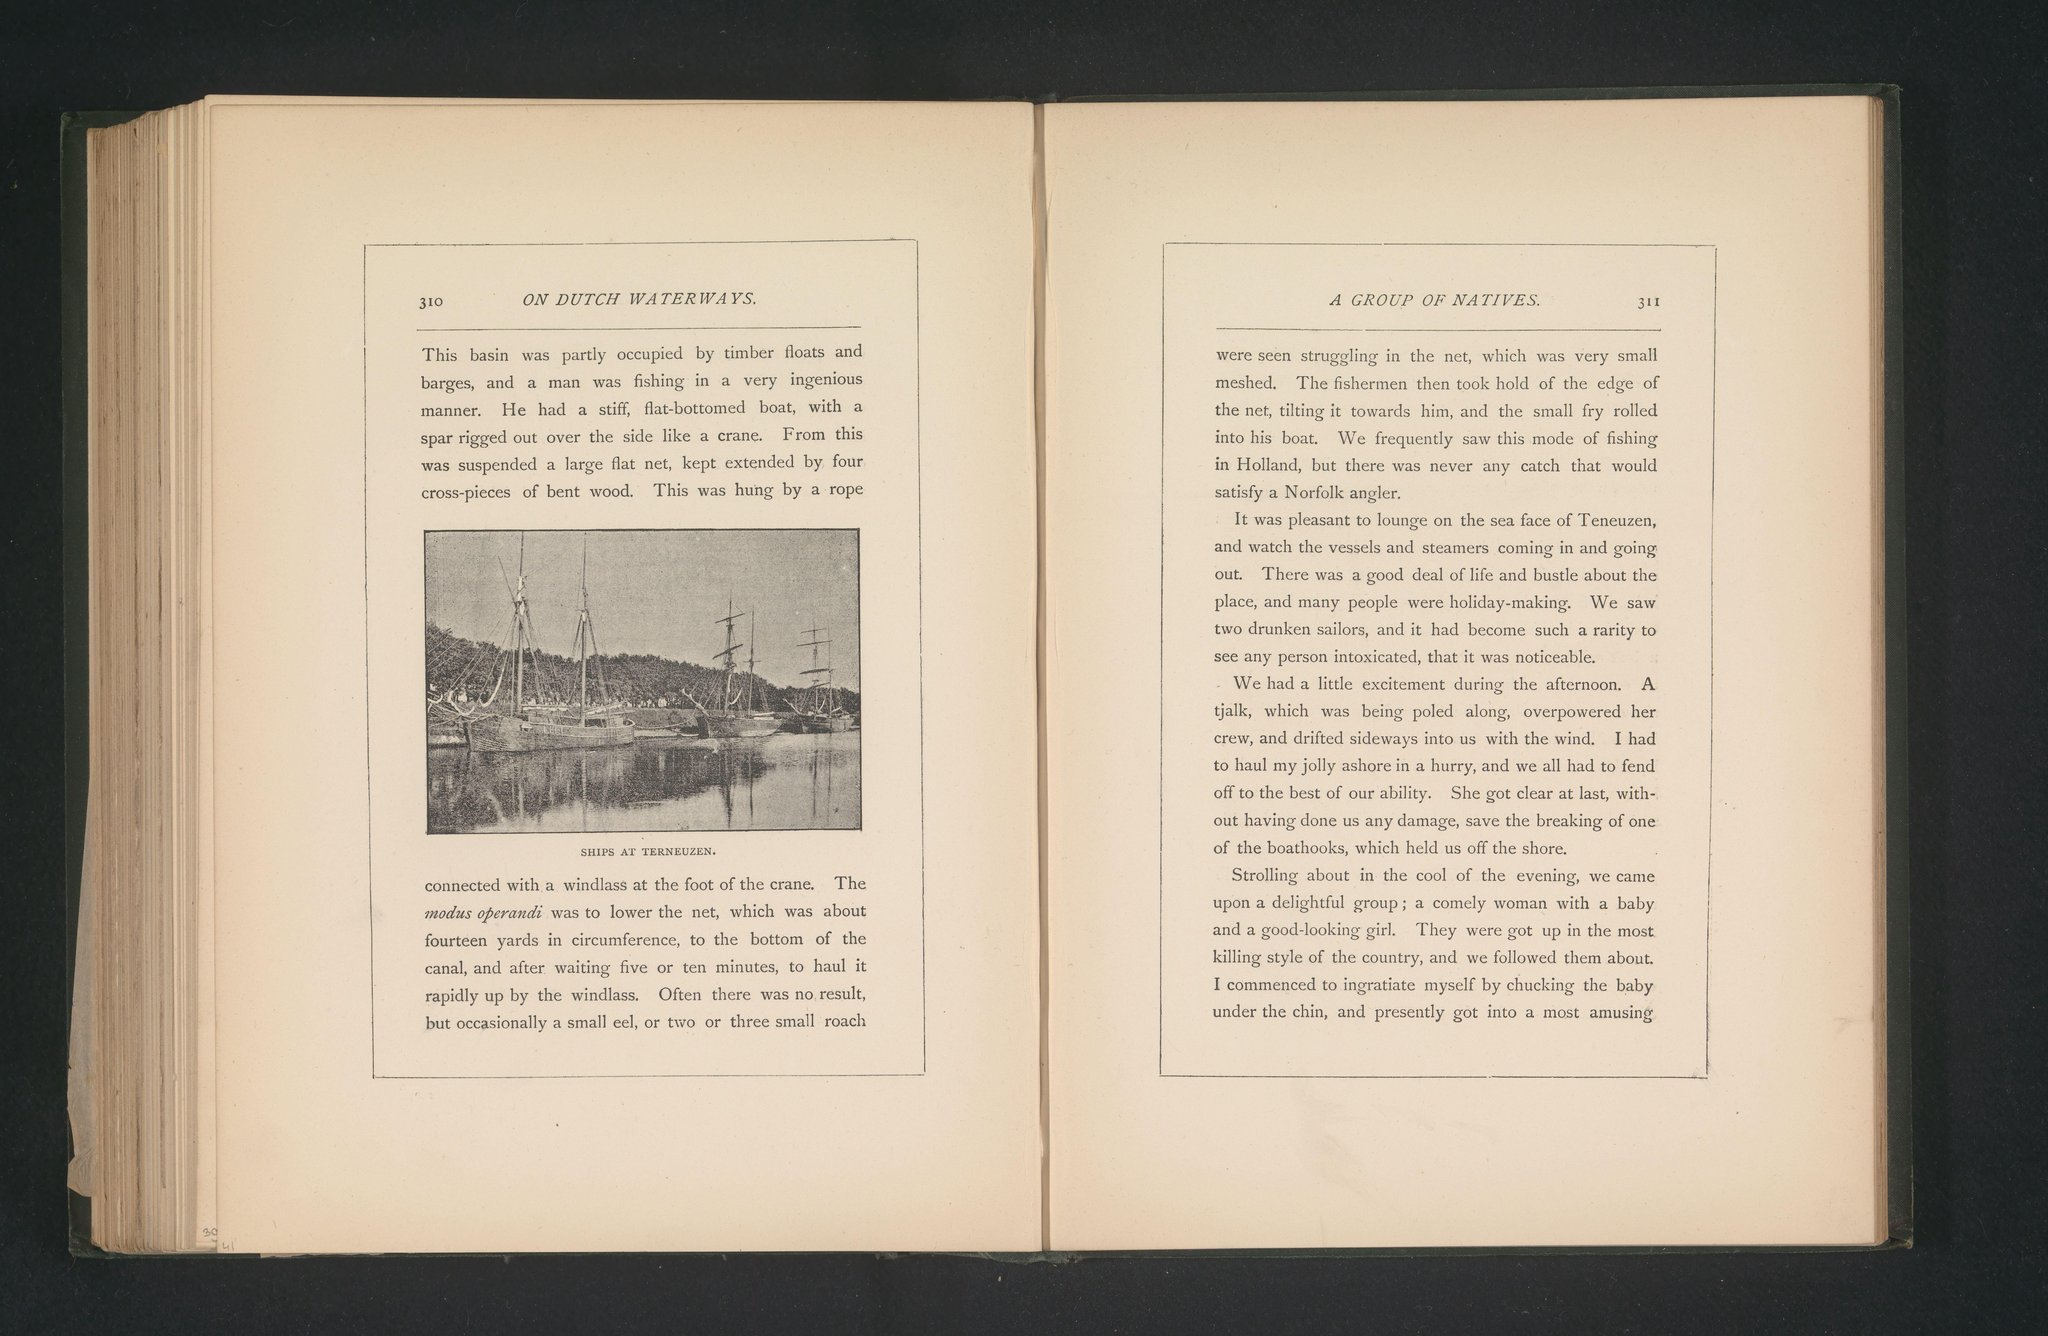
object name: page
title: Ships at Terneuzen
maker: george christopher davies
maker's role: fotograaf, geoloog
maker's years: 1849-1922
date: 1881-1886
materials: paper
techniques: autotype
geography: london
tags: sailing-ship, sailing-boat, pier, quay, wharf